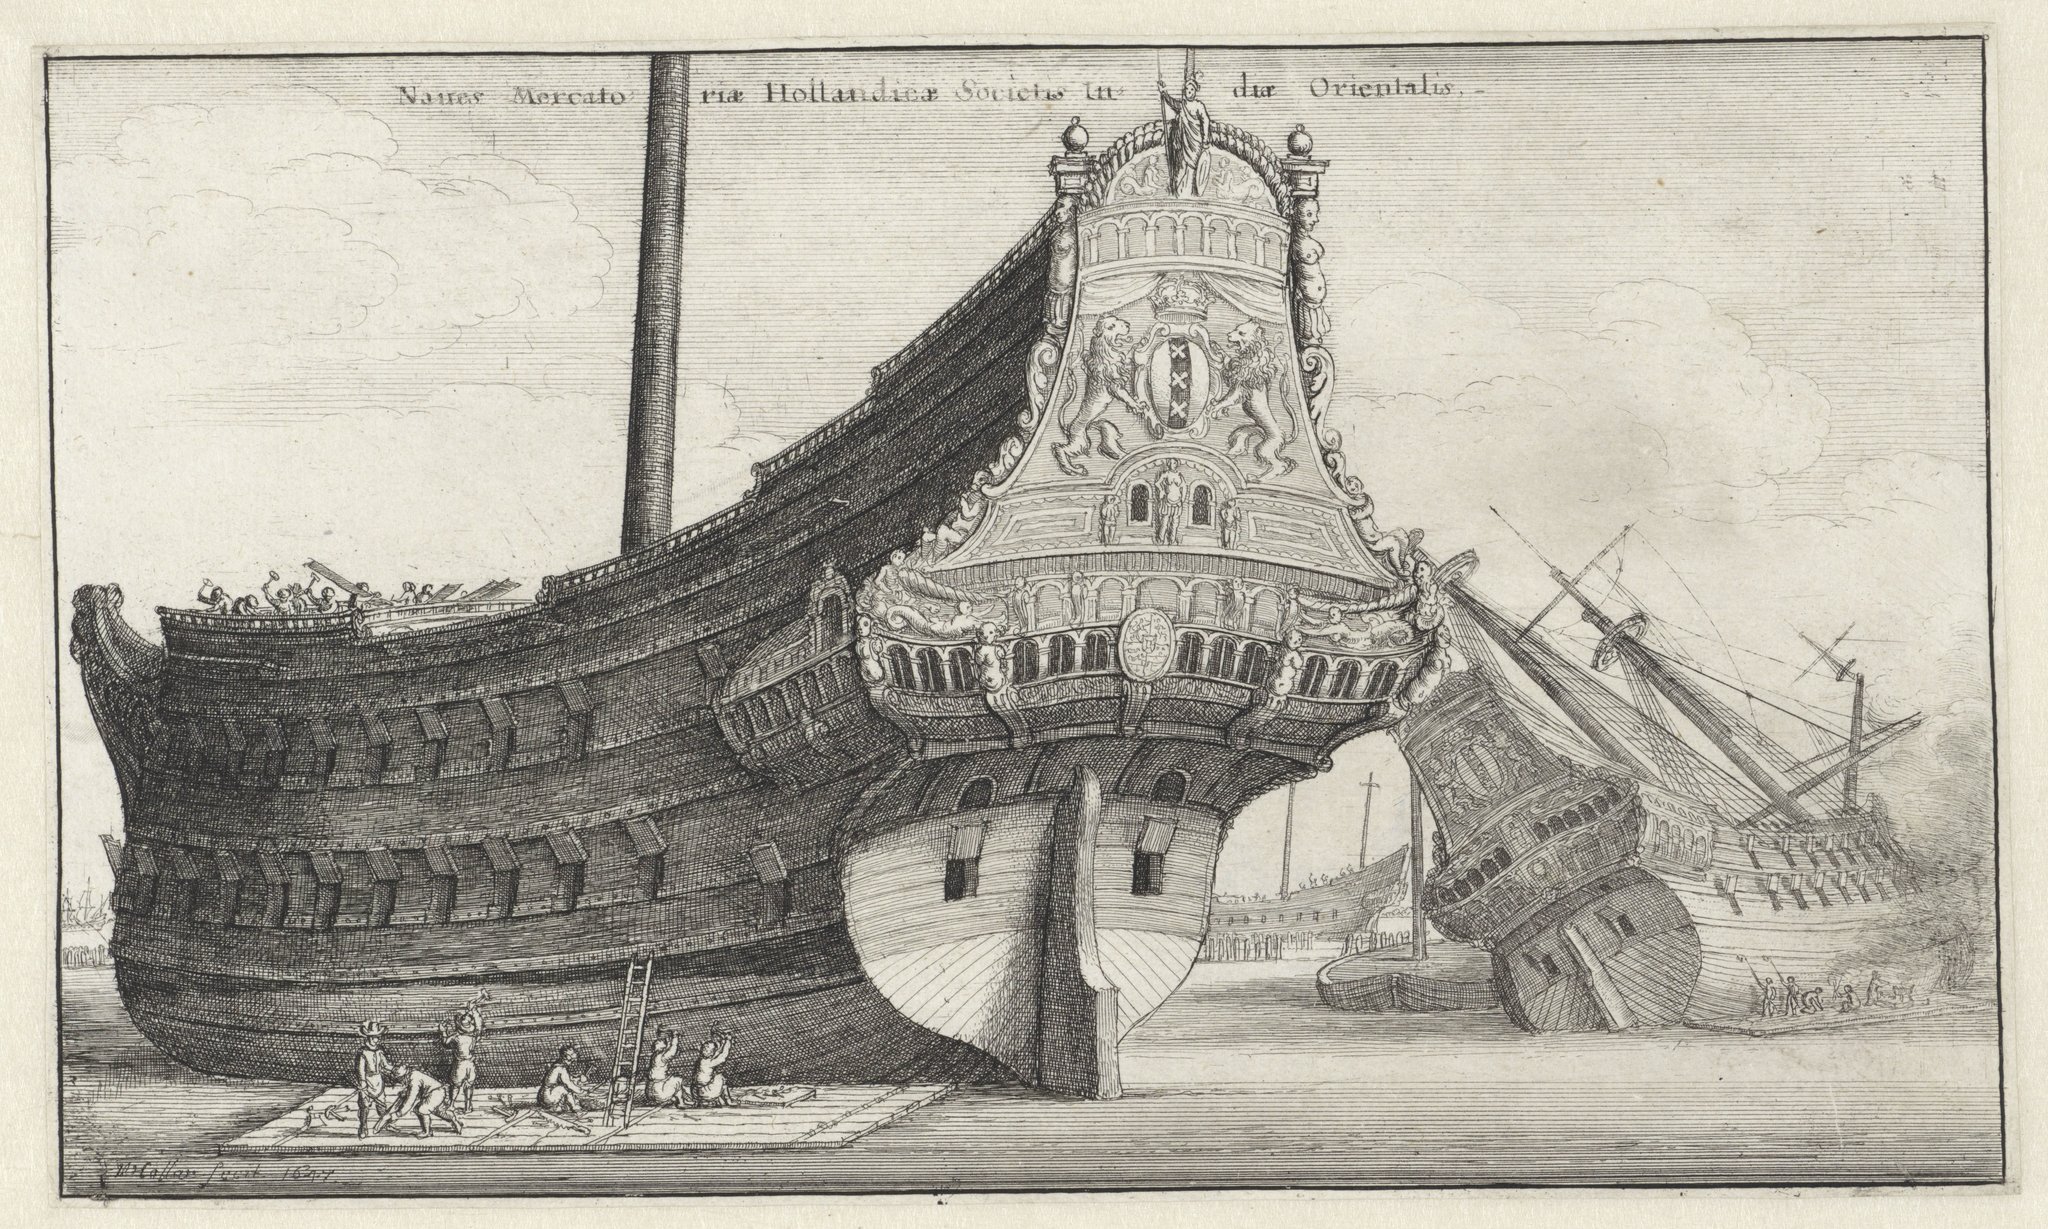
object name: print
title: Navium Variae Figurae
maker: wenceslaus hollar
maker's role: draughtsman, print maker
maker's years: 1607-1677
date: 1647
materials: paper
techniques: etching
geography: antwerp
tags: building a ship, ship under construction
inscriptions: collector's mark: Lugt 240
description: De prent maakt deel uit van de twaalfdelige serie "Navium Variae Figurae".